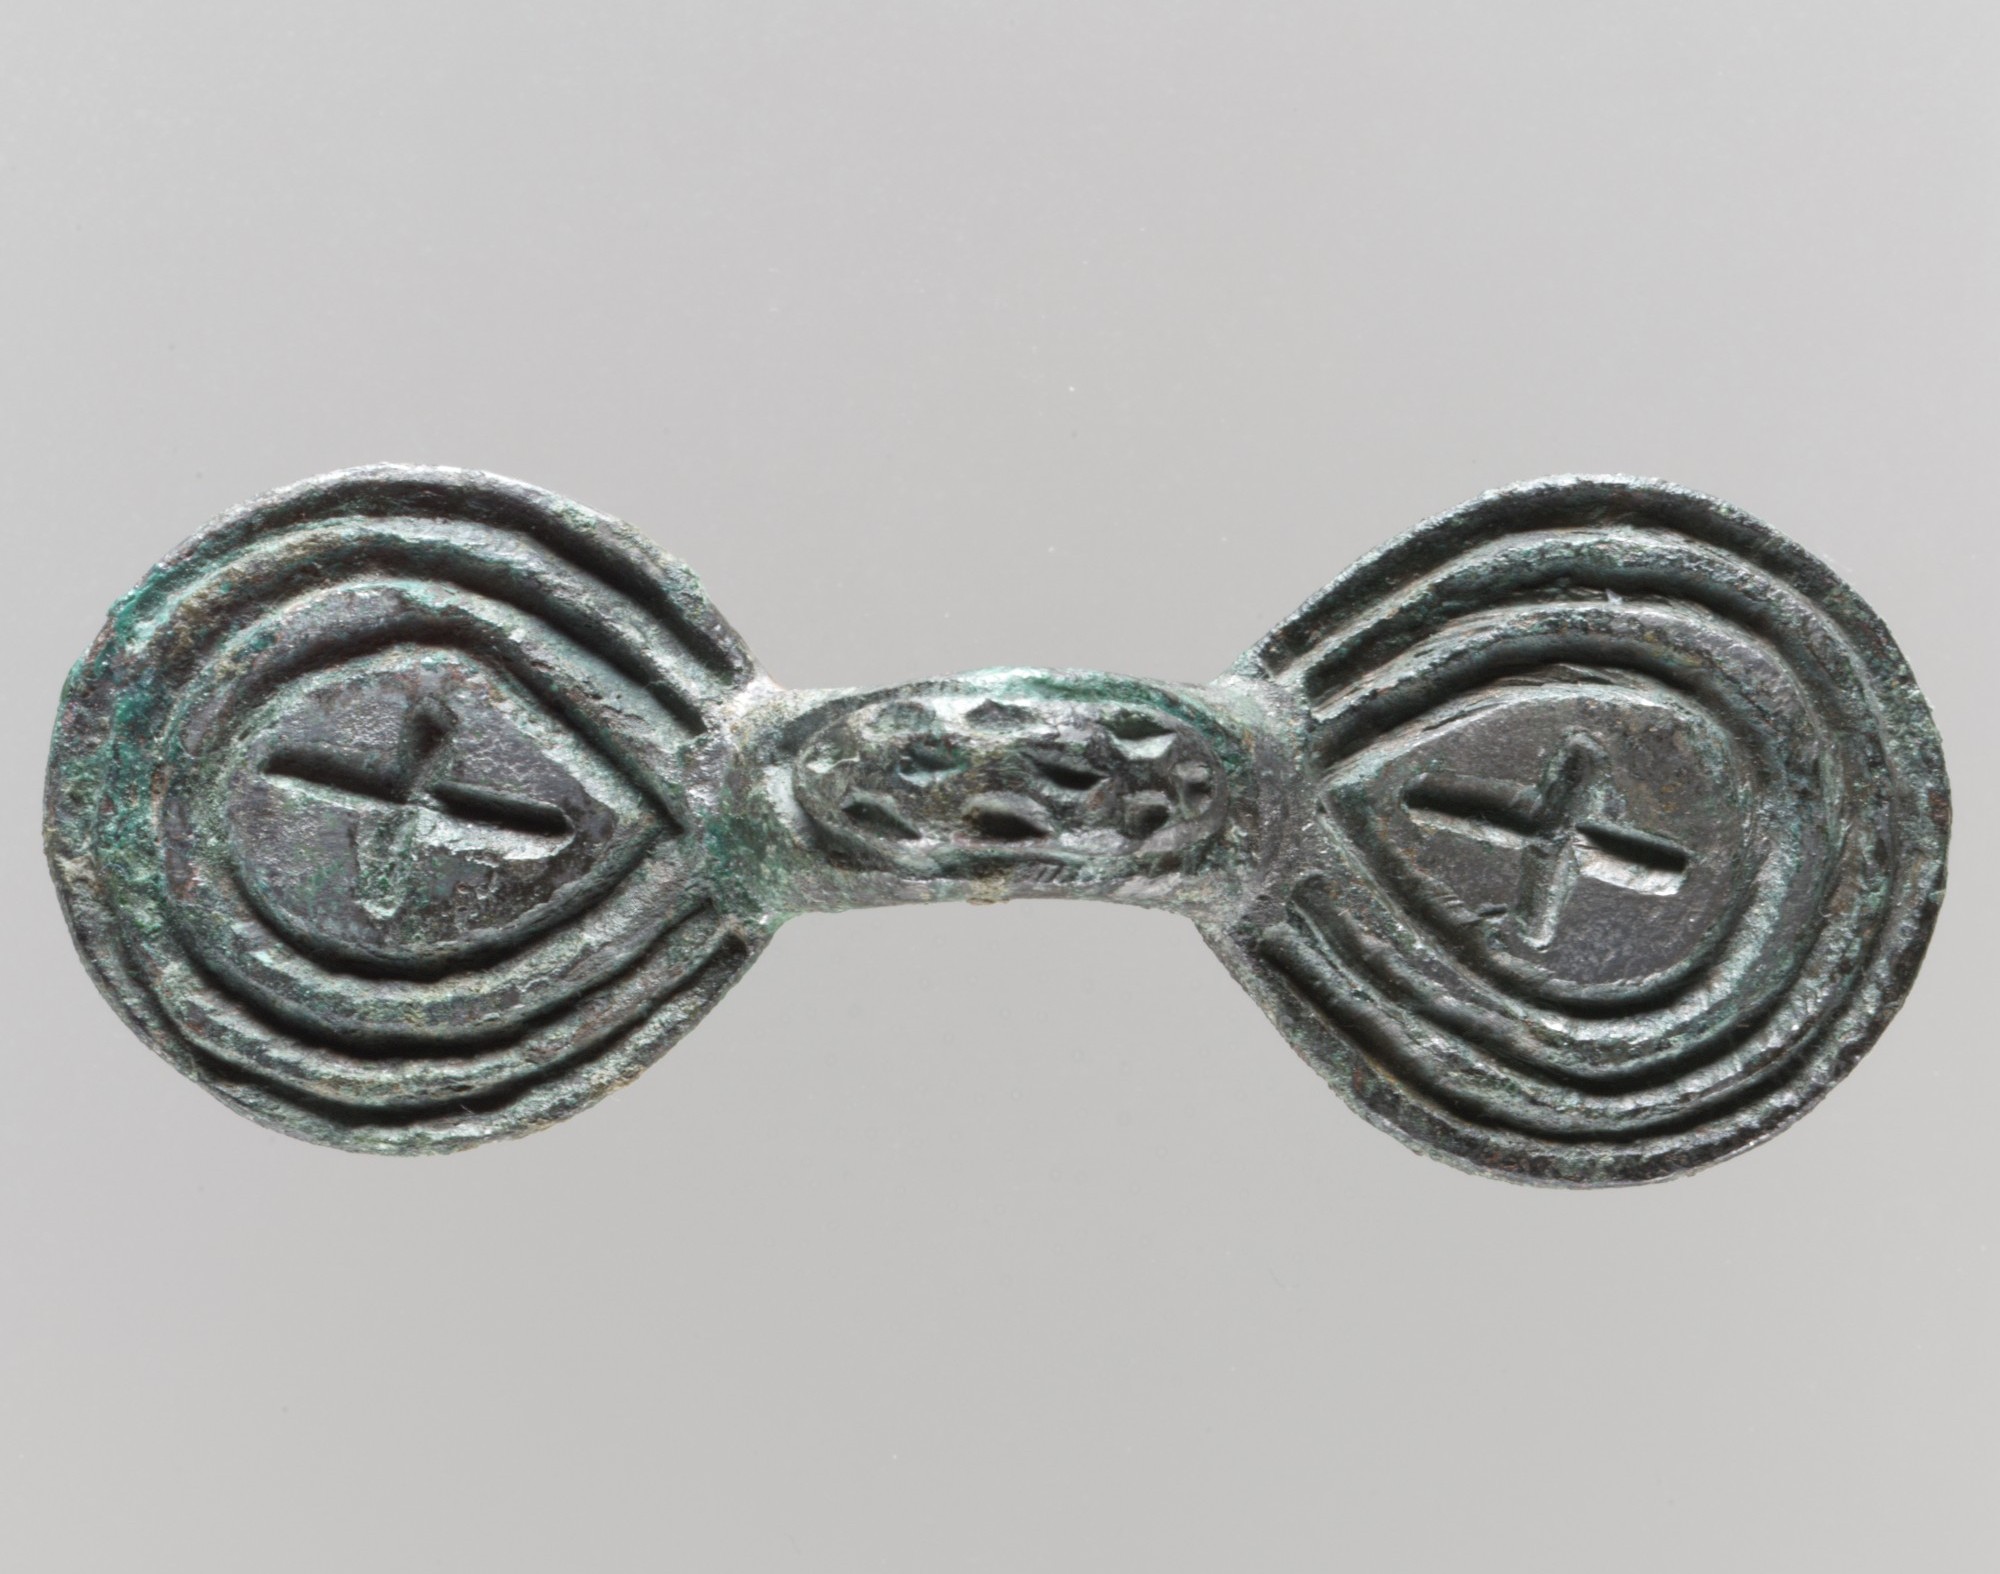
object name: brooch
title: Equal-Arm Brooch with Cross Decoration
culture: frankish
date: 601-800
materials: copper alloy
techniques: casting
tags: cross